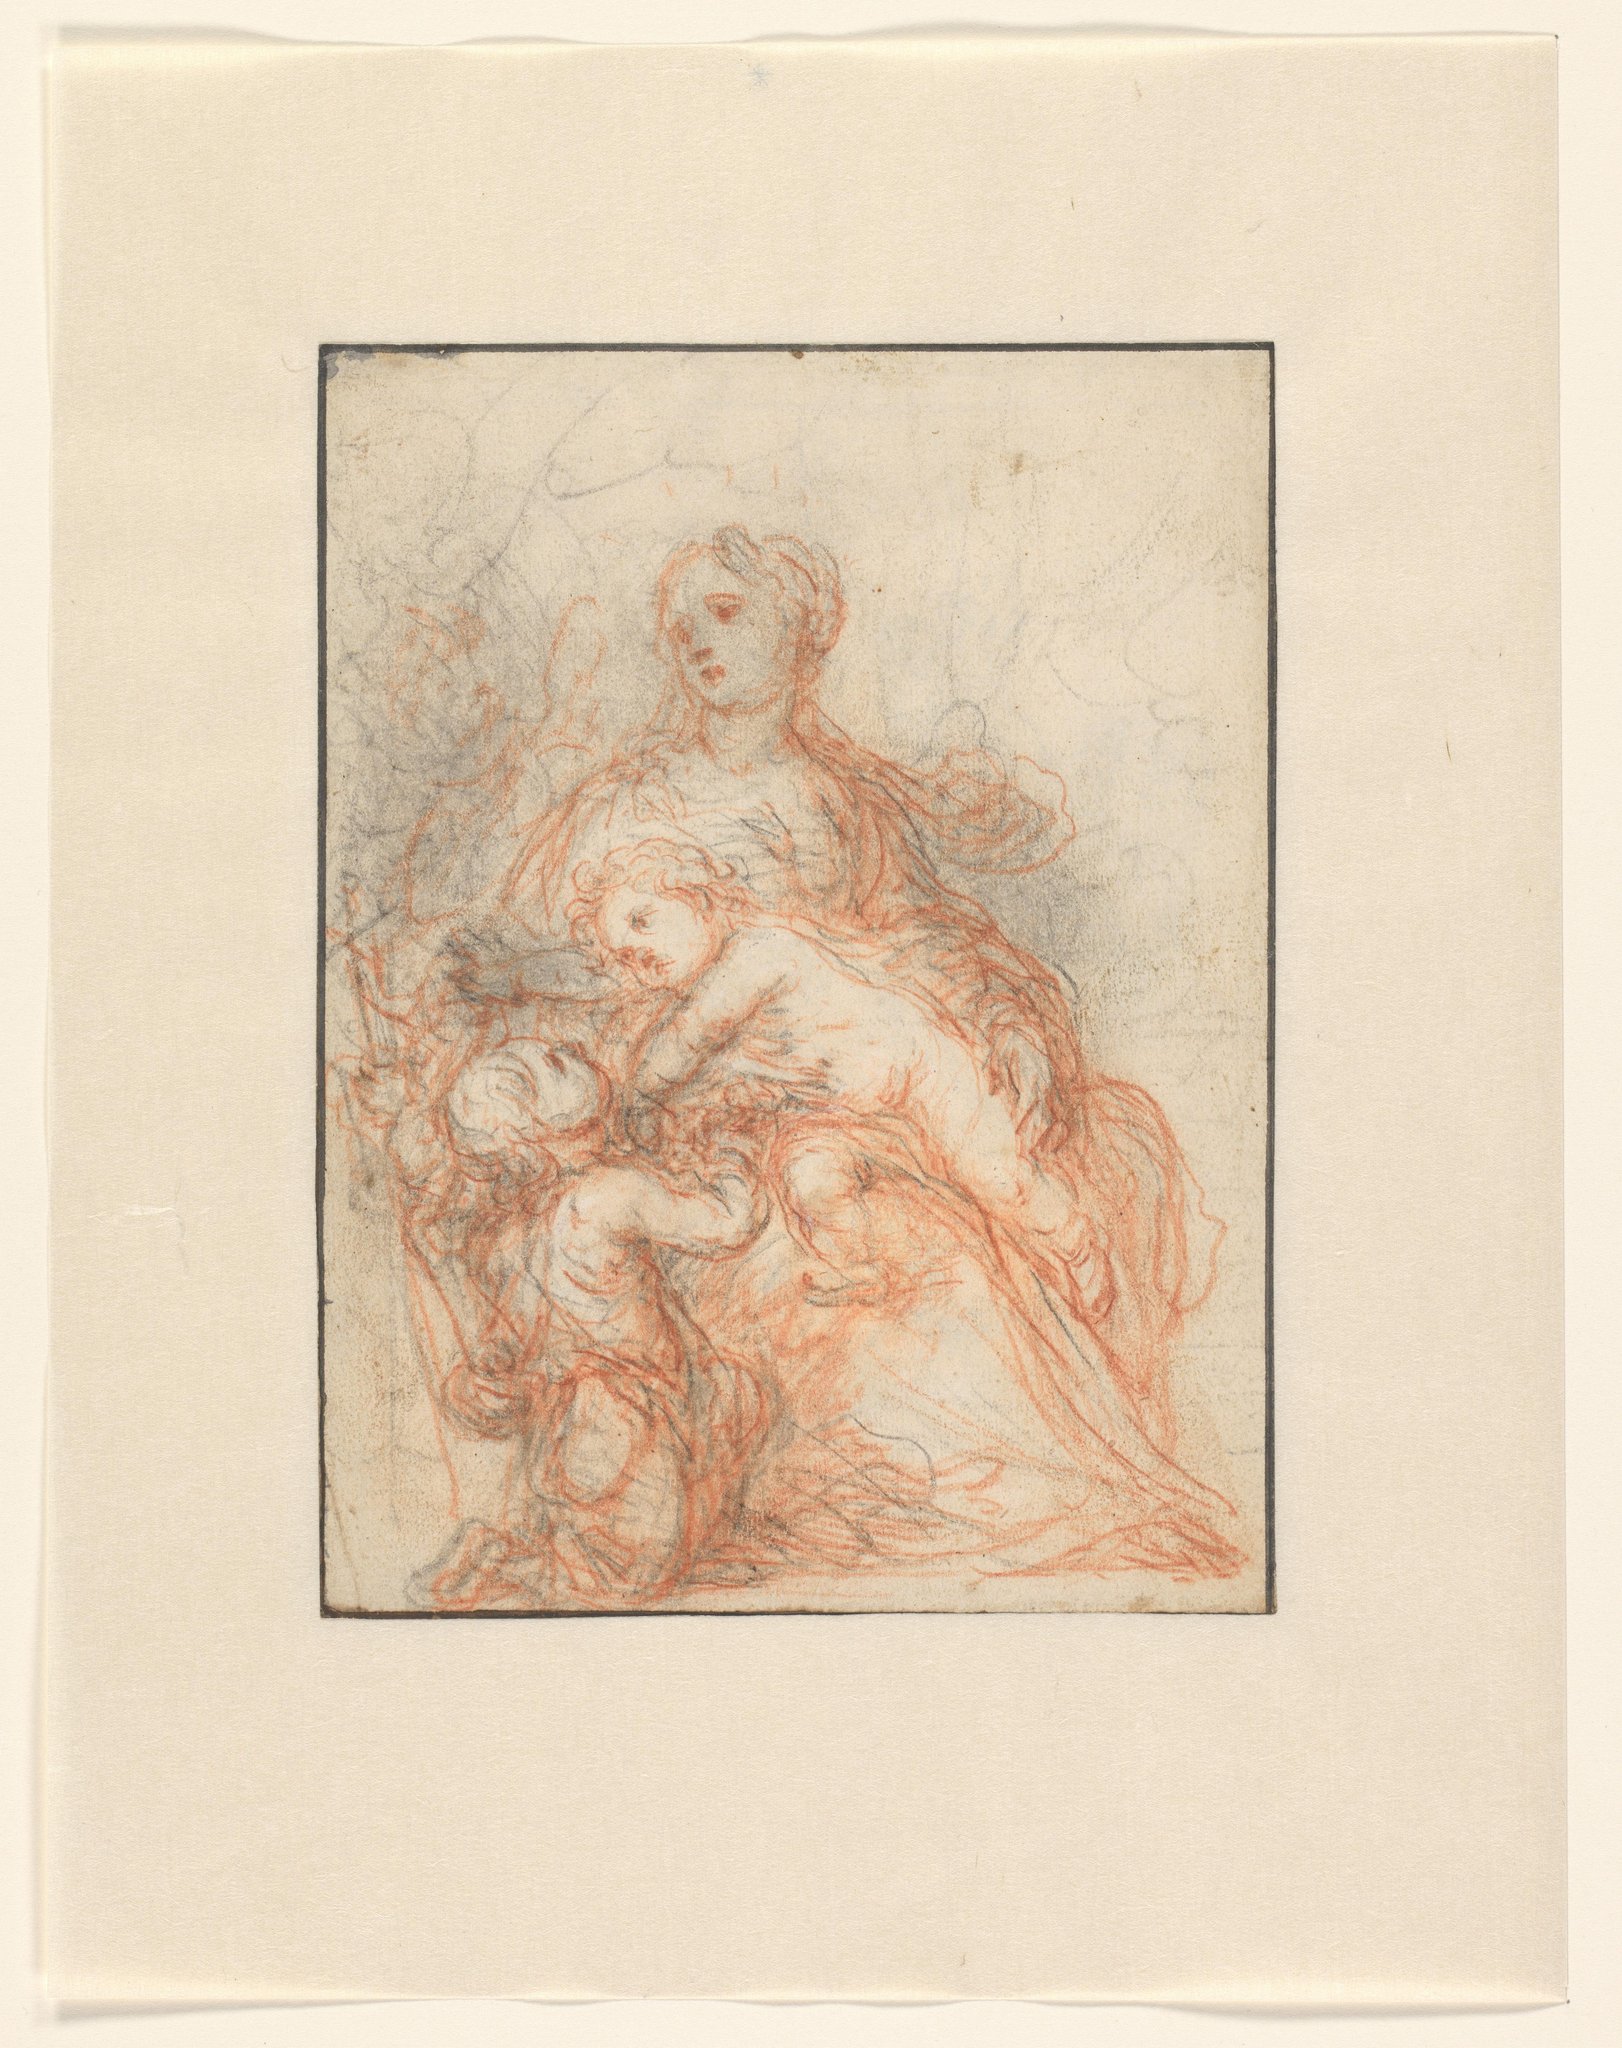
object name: drawing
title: Zittende Madonna met Christuskind en de jonge Johannes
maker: Anonymous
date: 1625-1675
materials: chalk, paper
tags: mary and the christ-child with john the baptist (as child), madonna (i.e. mary with the christ-child) accompanied or surrounded by others